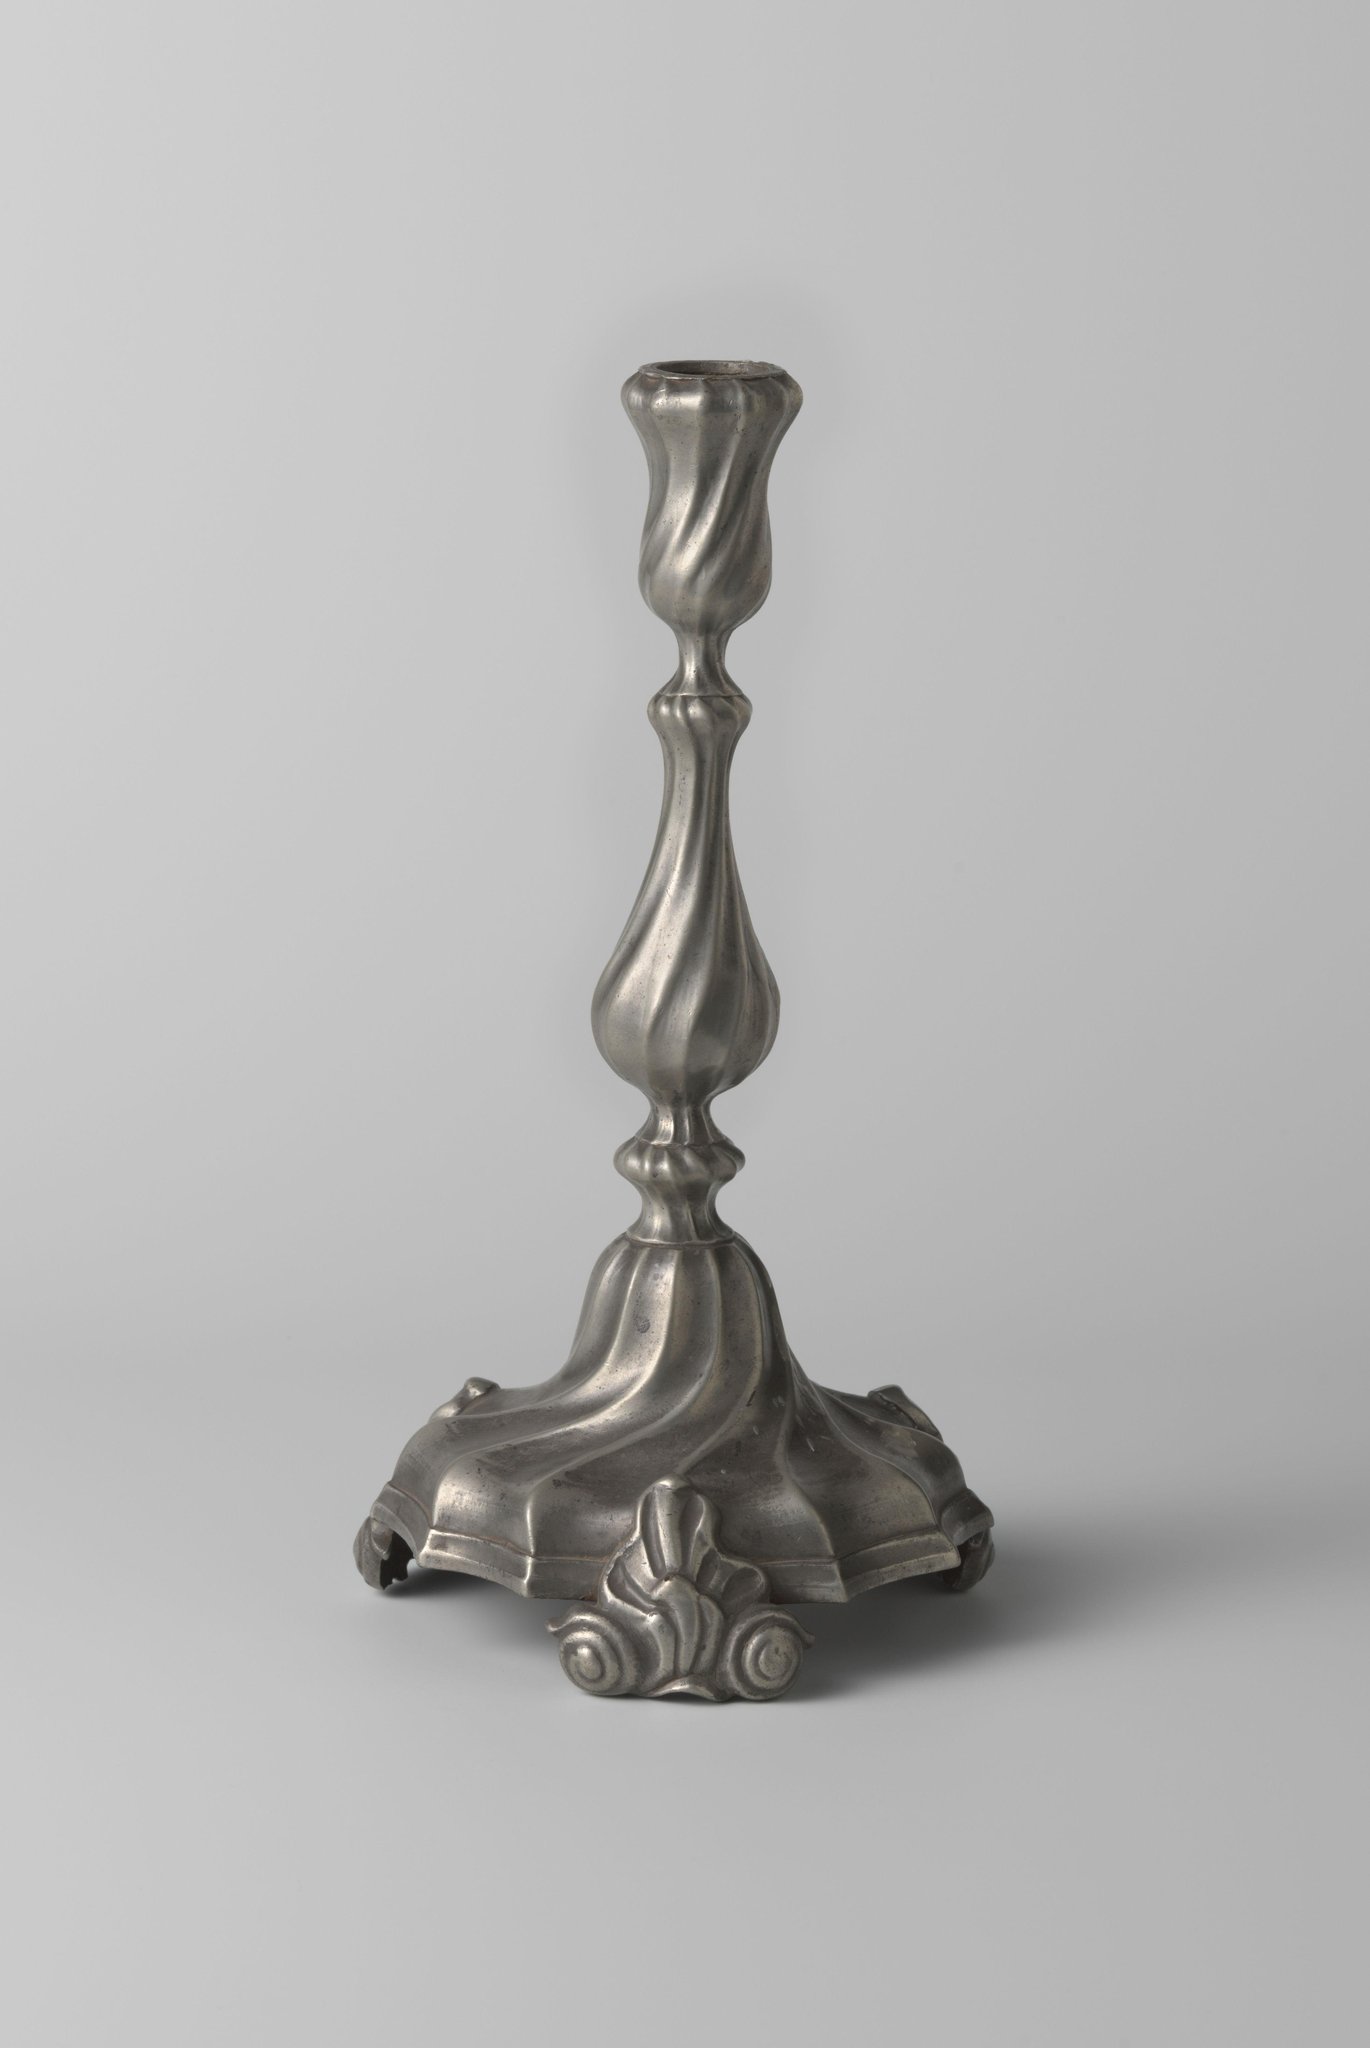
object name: candlestick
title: Kandelaar van tin, getordeerd model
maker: Anonymous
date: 1700-1800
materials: tin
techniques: casting, turning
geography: western europe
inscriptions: quality mark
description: Kandelaar van tin. De getordeerde voet staat op drie lage poten, gevormd door voluten. De balustervormige stam is getordeerd met een daarboven een getordeerde bokaalvorm. De bloemvormige vetvanger ontbreekt.